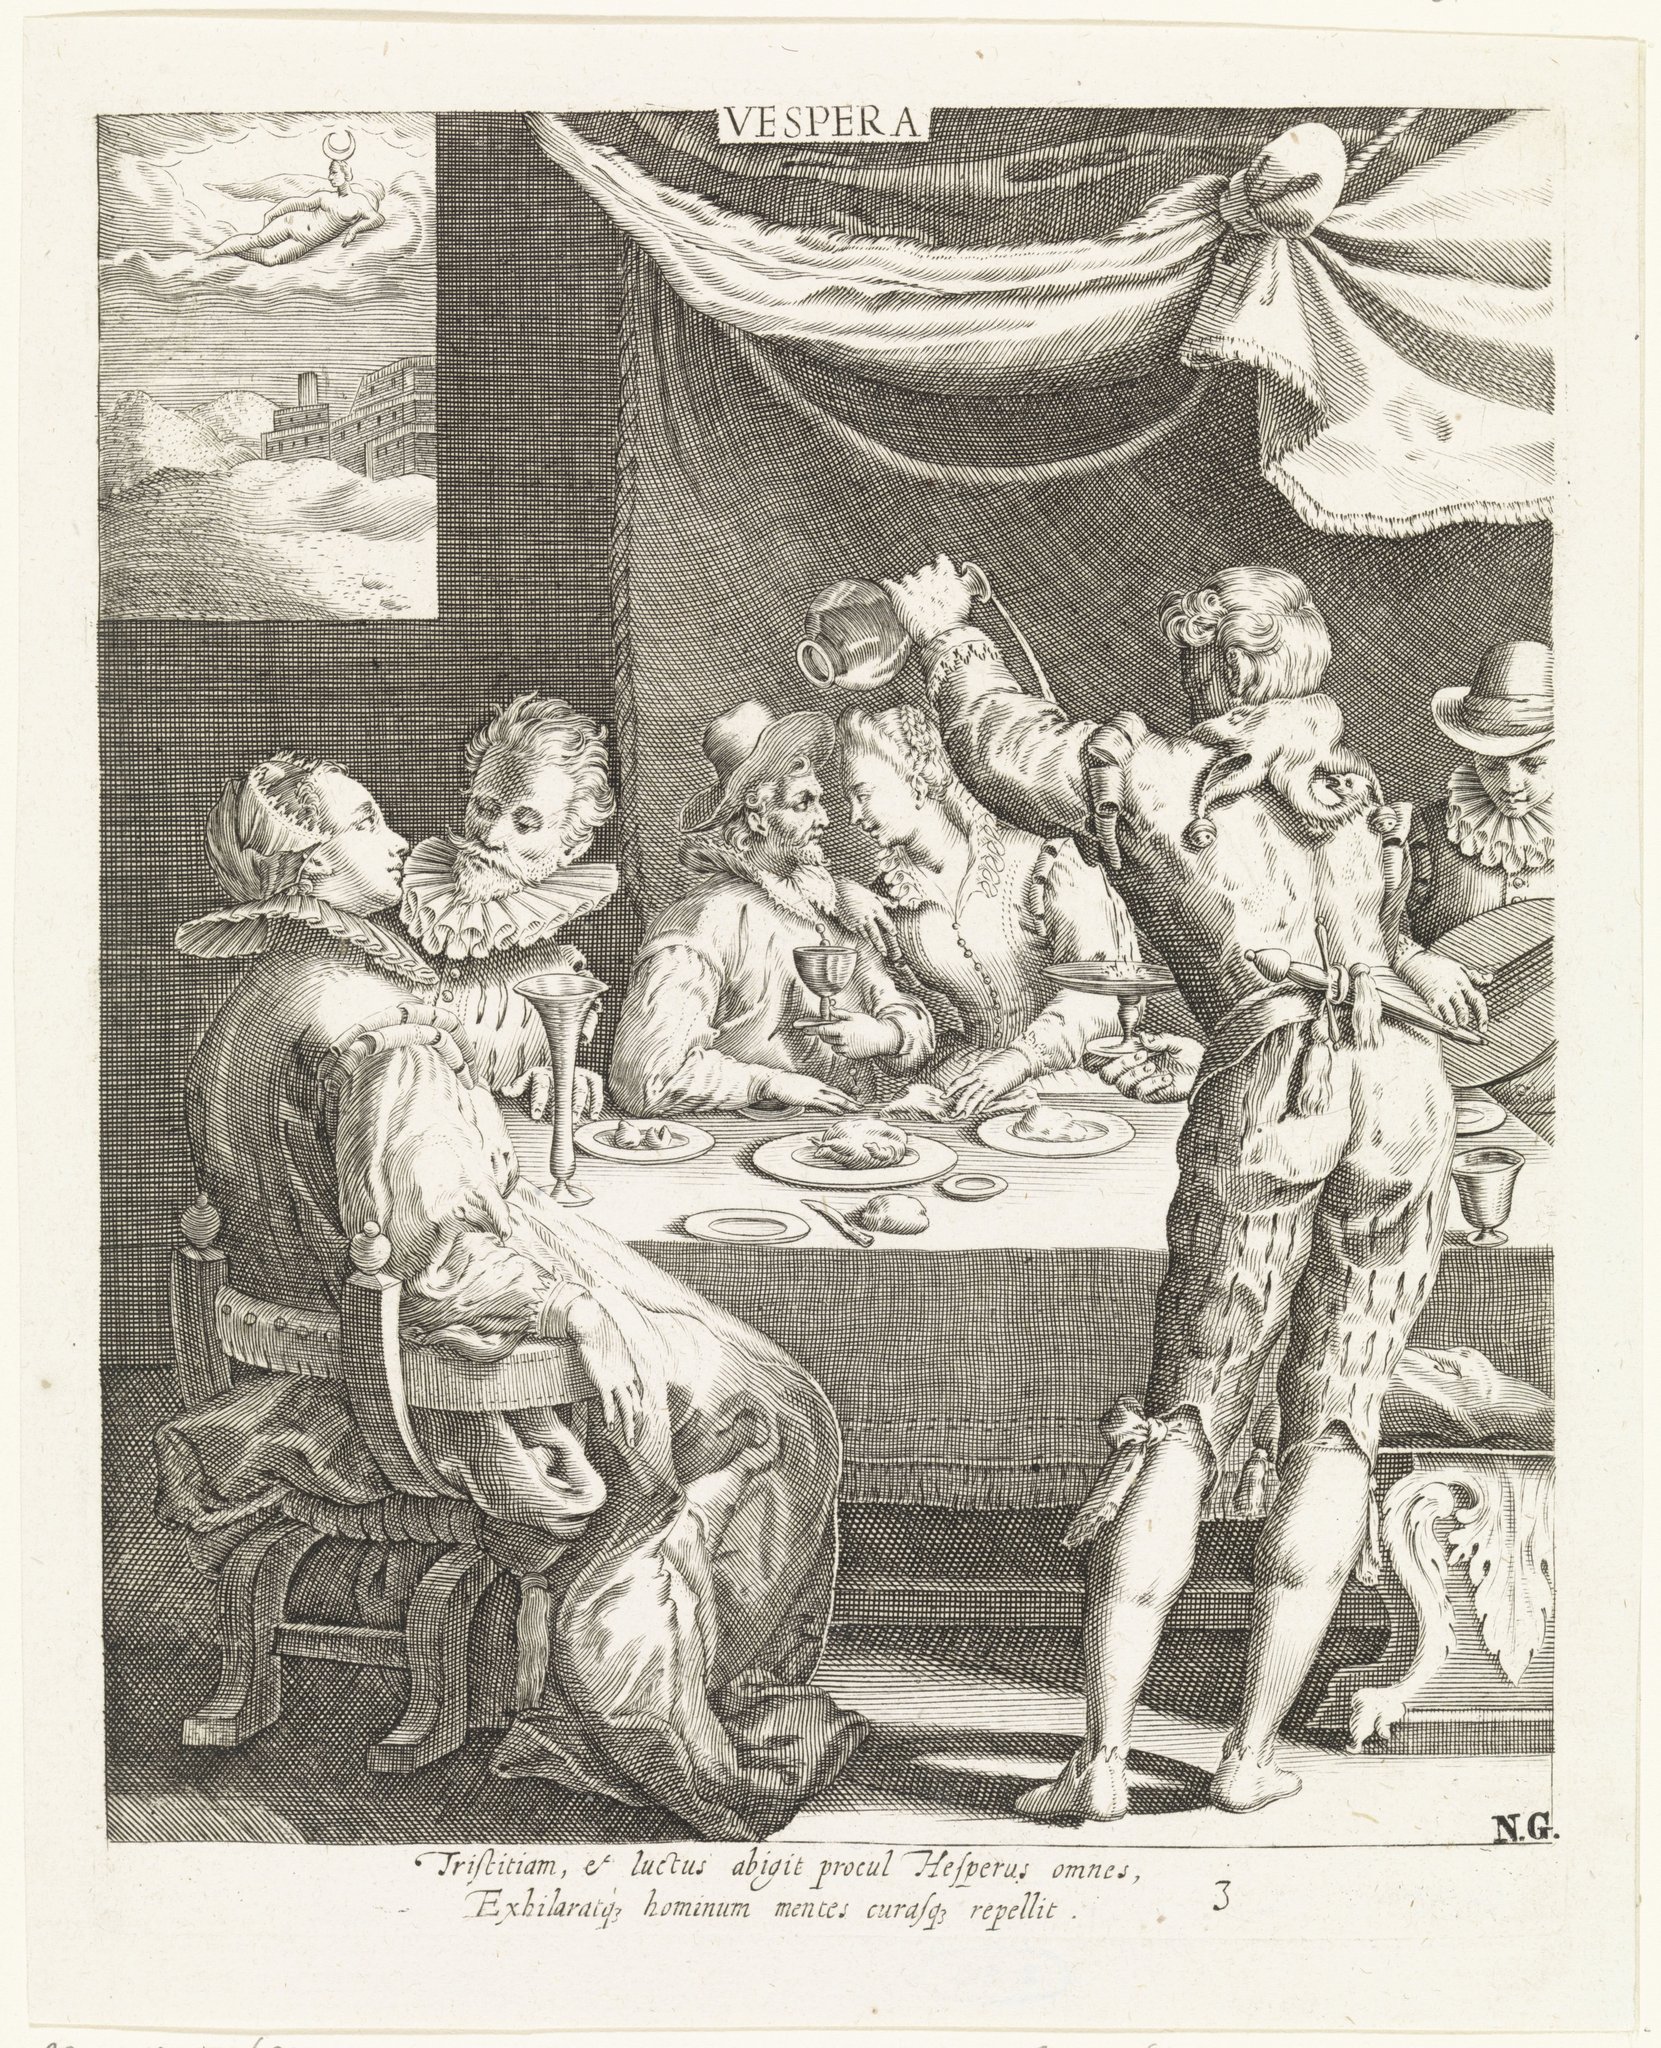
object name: print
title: De vier tijden van de dag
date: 1630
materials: paper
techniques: engraving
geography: northern netherlands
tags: diana lucina, evening, banquet of elegant company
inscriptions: collector's mark: Lugt 2228, collector's mark: Lugt 1967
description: Elegant gezelschap aan een rijk gevulde tafel. Een bediende, op de rug gezien, schenkt wijn in. Door een venster is de godin Diana te zien op een wolk boven een feestvierend gezelschap op straat.